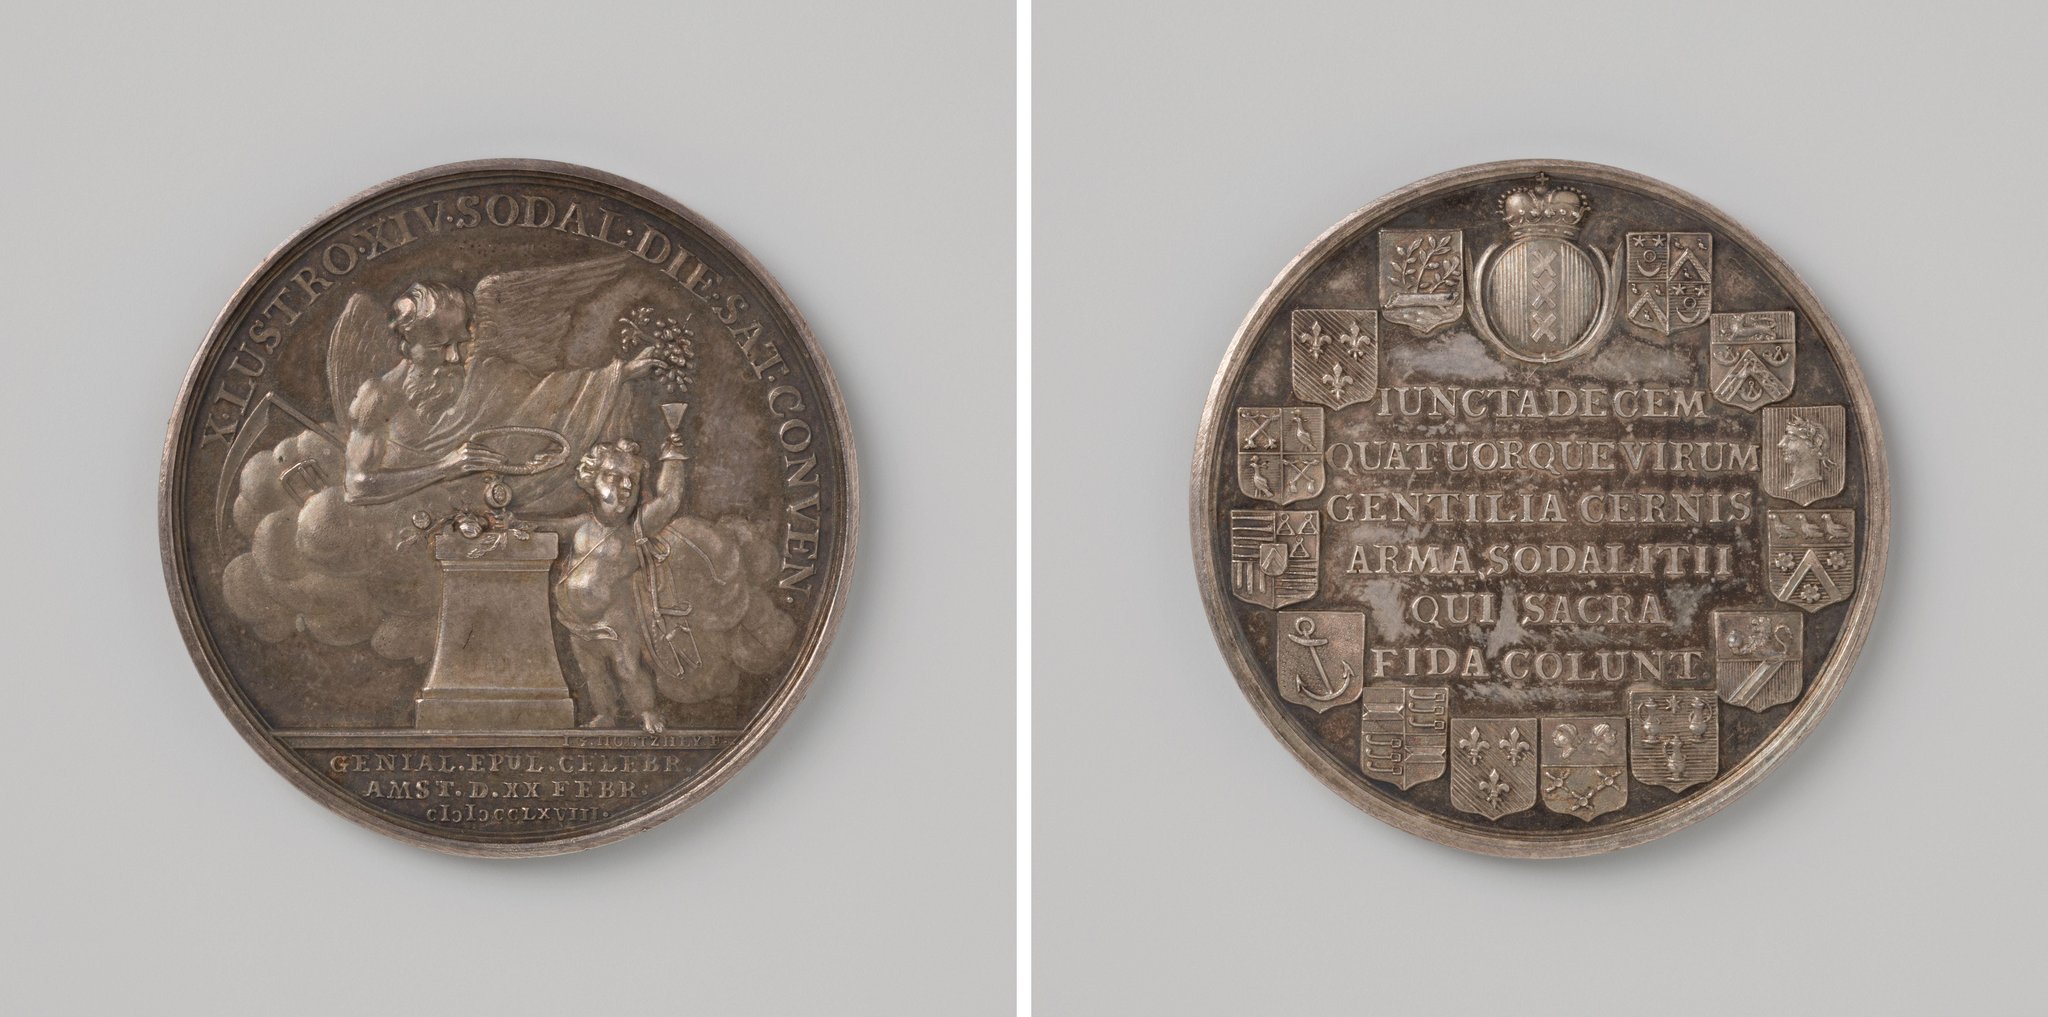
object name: history medal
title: Vijftigjarig bestaan van het Saturdags Geselschap te Amsterdam 1768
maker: johan george holtzhey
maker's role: mintmaster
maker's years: 1726-1808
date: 1768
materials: silver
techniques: striking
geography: amsterdam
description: Zilveren penning, op de voorzijde bij een altaar een gevleugeld knaapje, met paardentoom en granaatappel, een wijnglas ophoudend waaarin de gevleugelde Tijd, op een wolk met zeis en slangenrond, een druiventros uitknijpt, met omschrift en afsnedetekst, op de keerzijde zes regels tekst binnen een kring van familiewapens met bovenaan het gekroonde ronde wapenschild van Amsterdam.